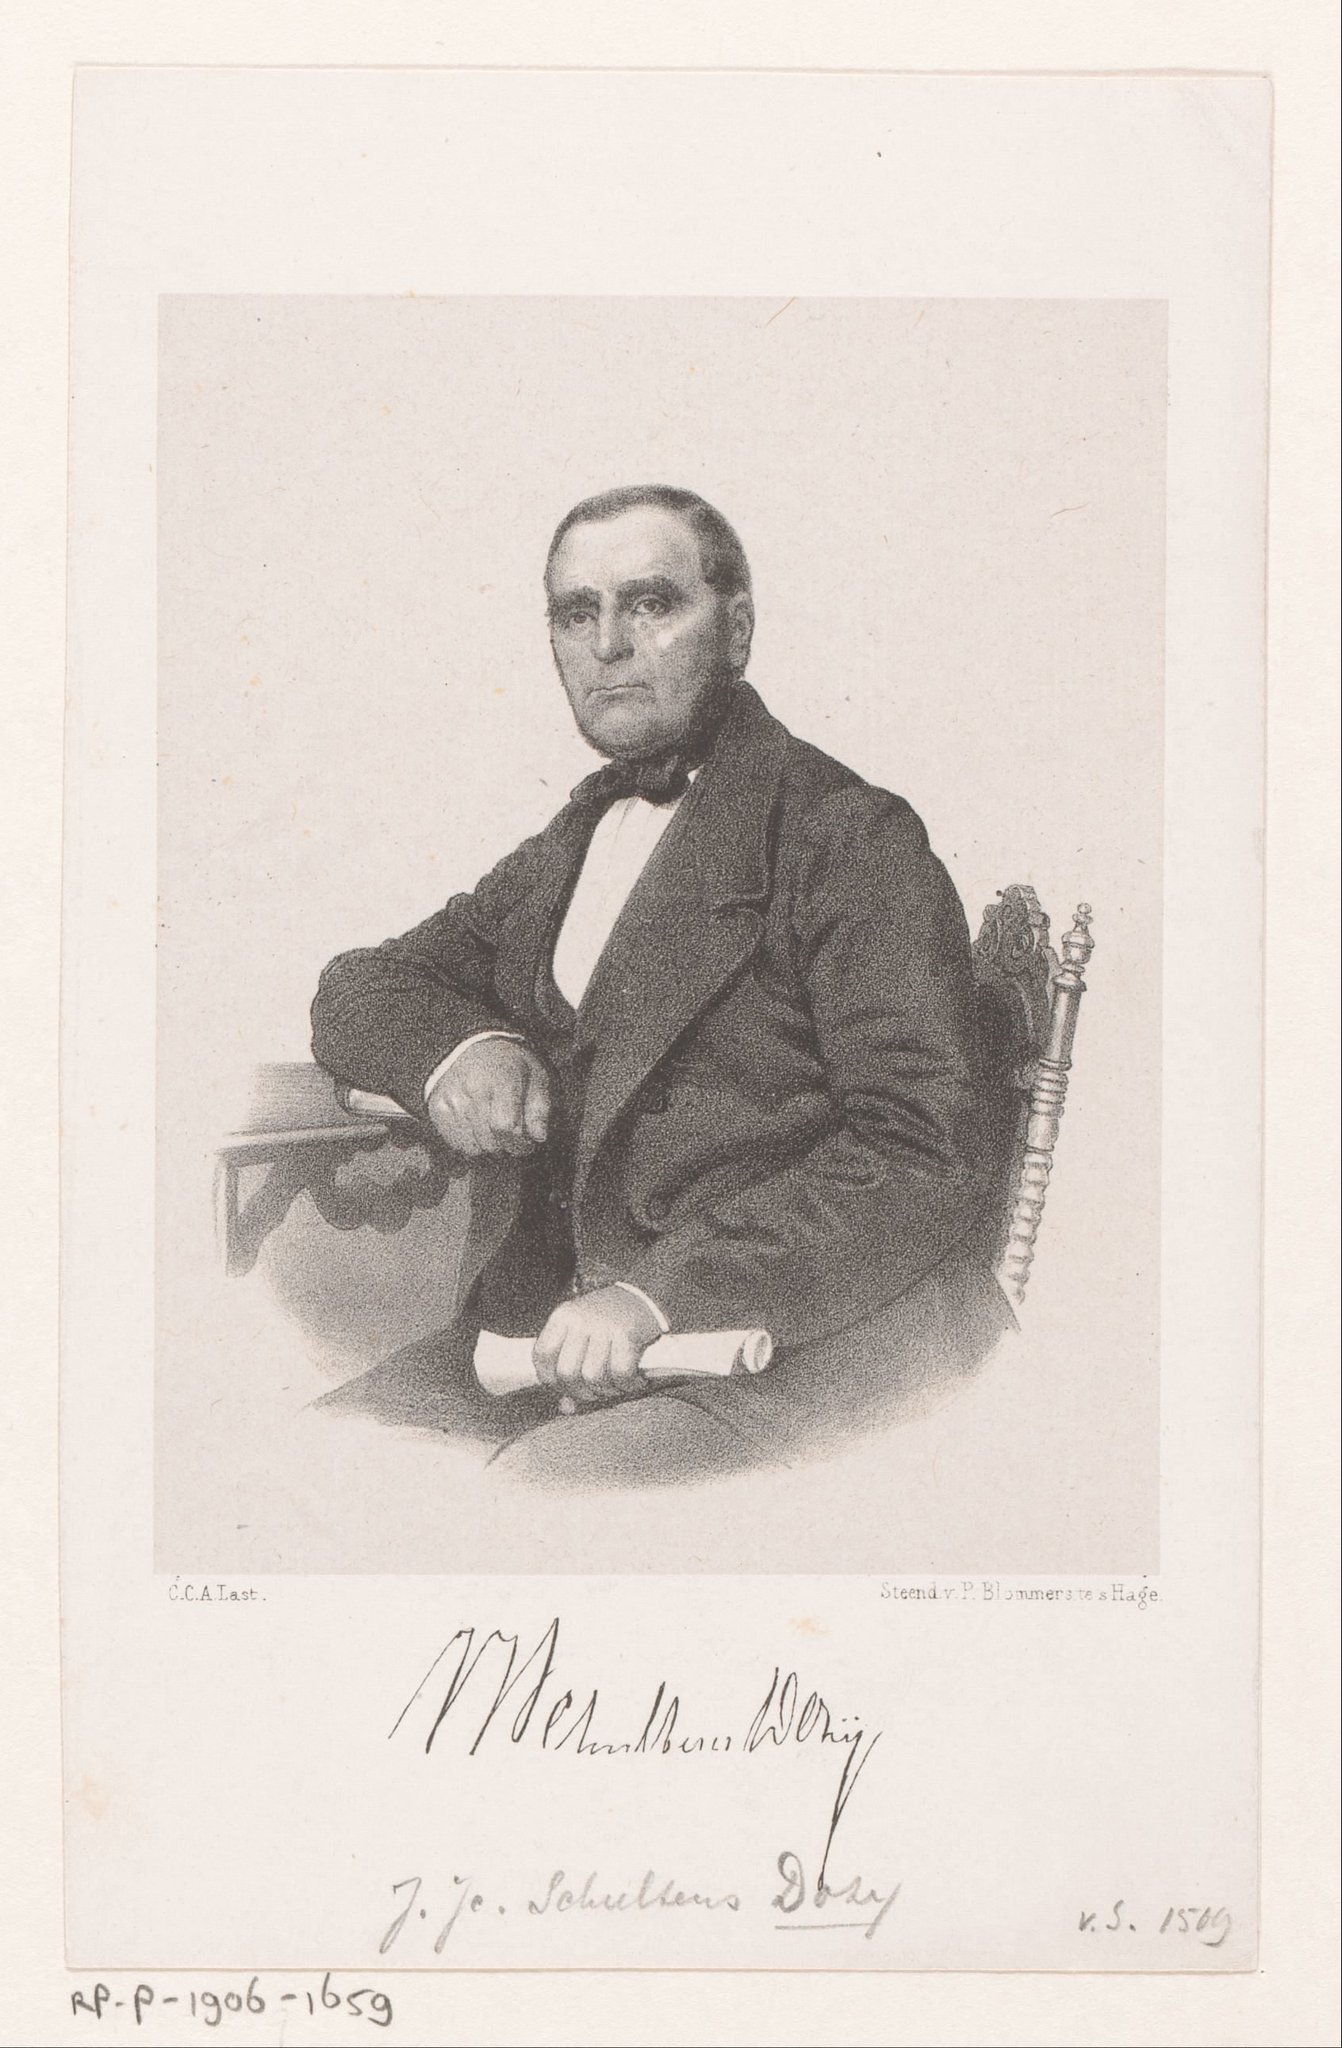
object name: print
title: Portret van J. Jc. Schultens Dozy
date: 1842-1887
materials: paper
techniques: lithograph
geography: the hague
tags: historical persons (+ half-length portrait)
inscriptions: collector's mark: Lugt 2228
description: Schultens Dozy was directeur van het postkantoor te Hoorn. Hij zit aan een tafel. Onder het portret zijn signatuur.